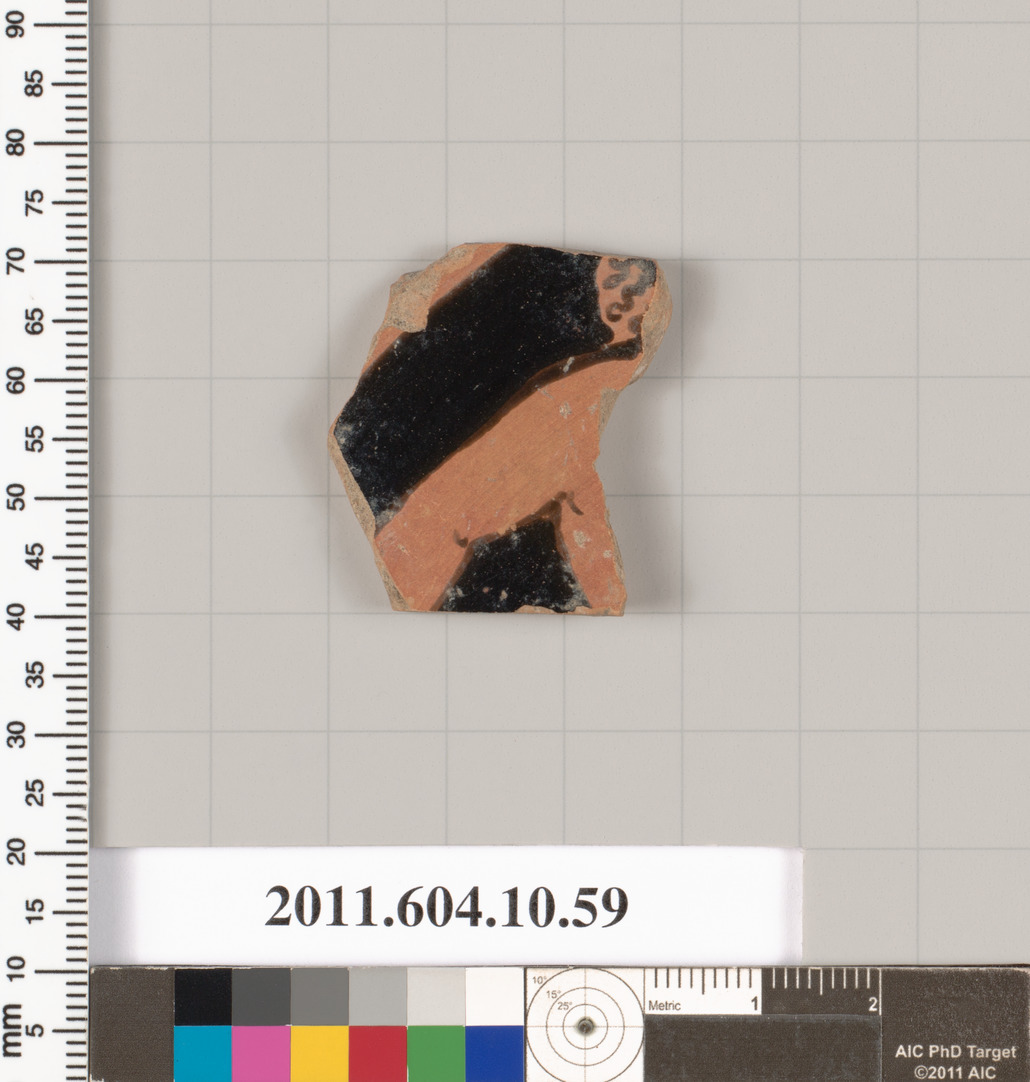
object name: kylix fragment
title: Terracotta fragment of a kylix (drinking cup)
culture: etruscan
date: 334-301 BCE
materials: terracotta